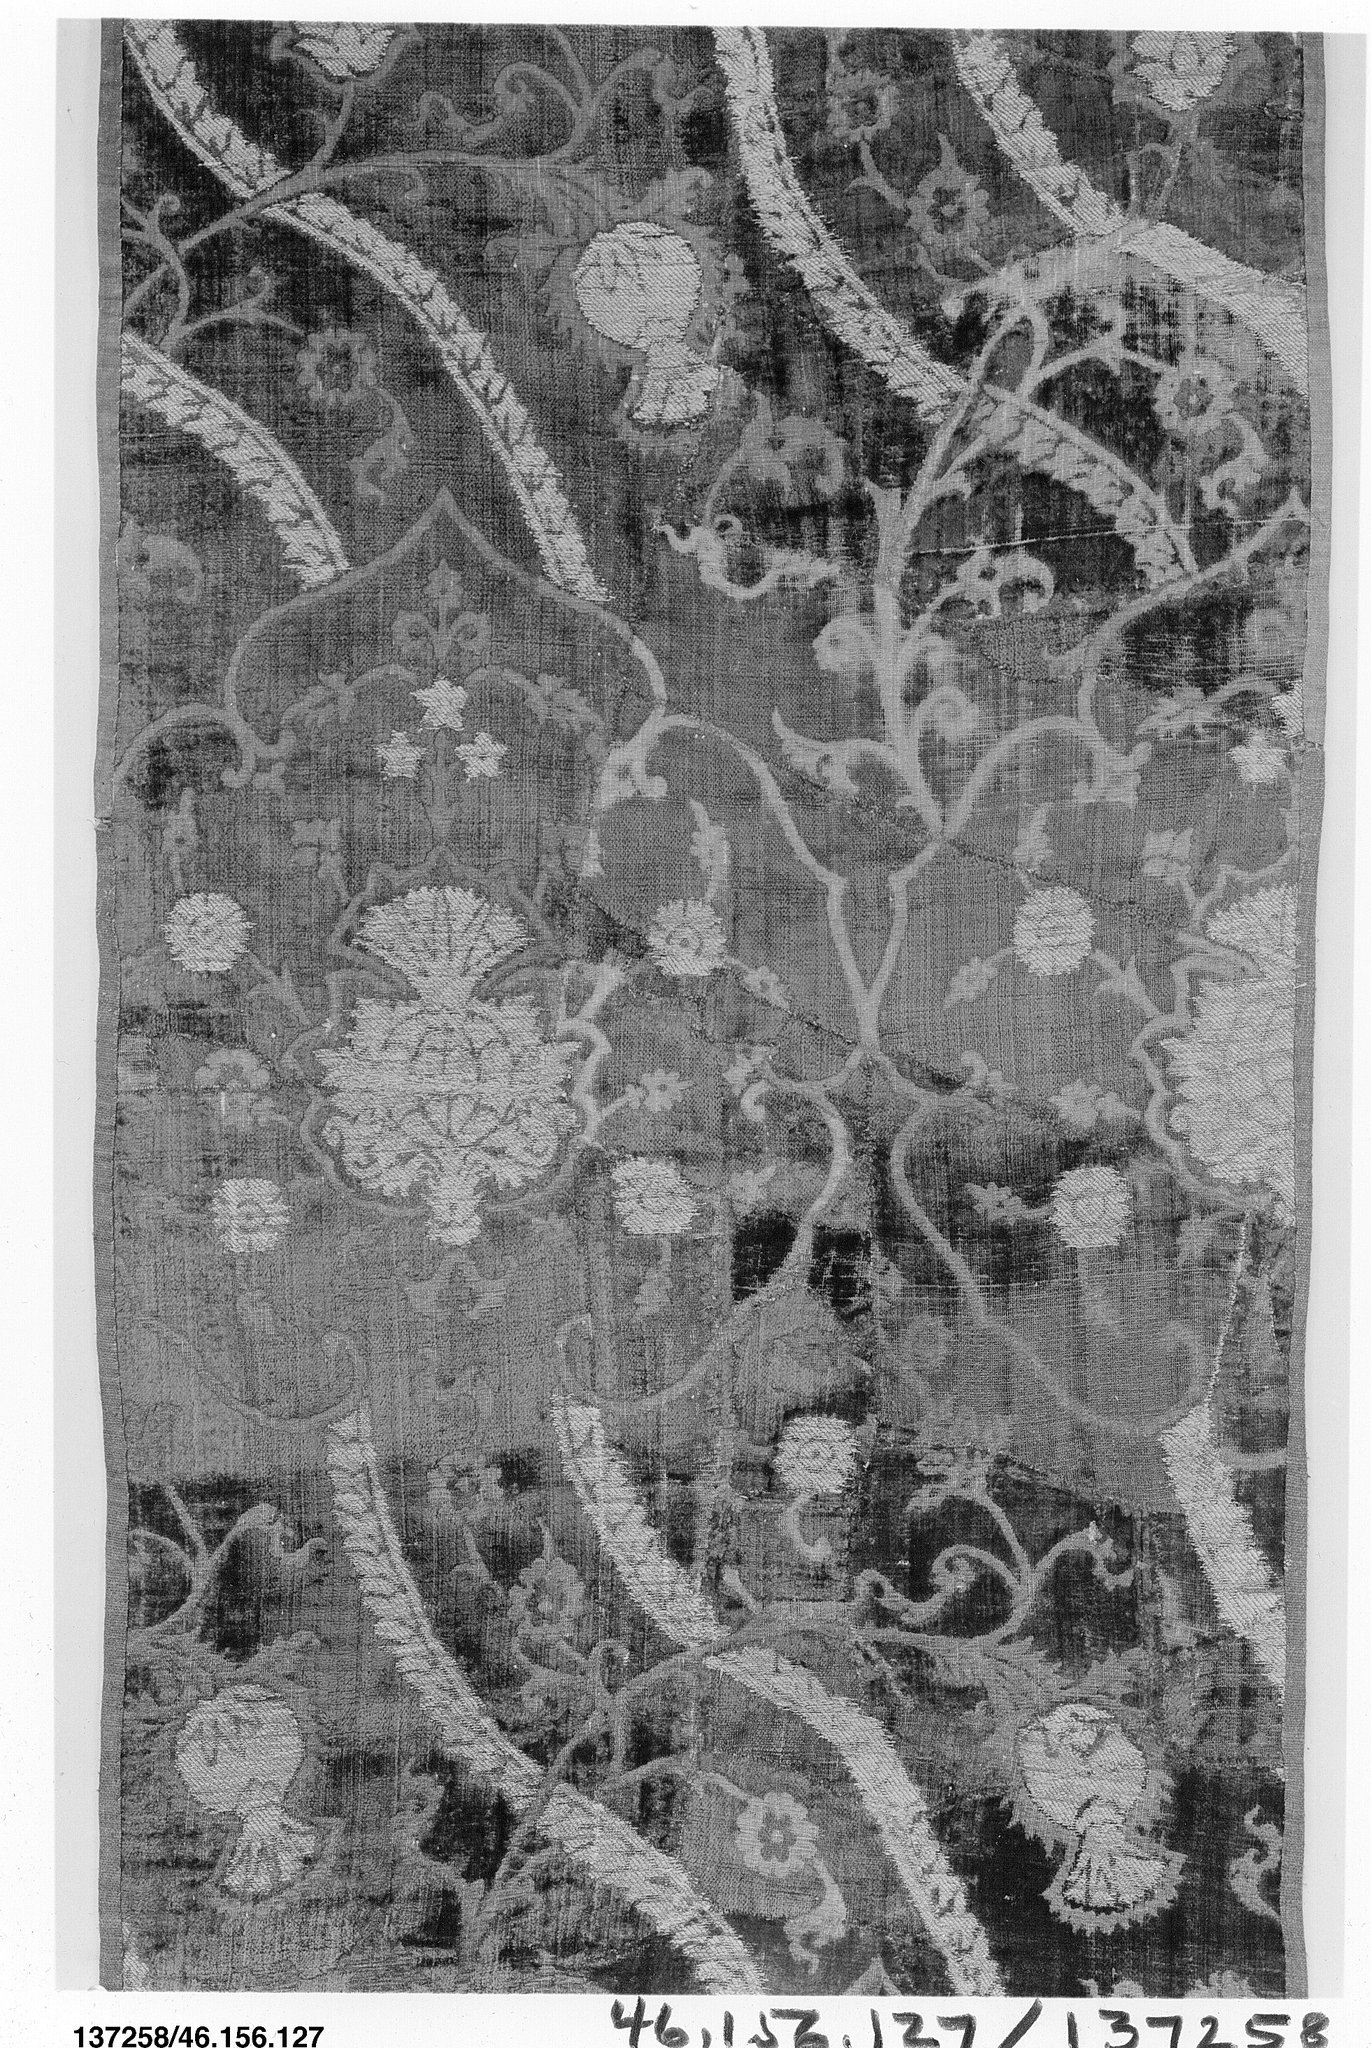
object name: piece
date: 1451-1500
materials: metal thread, silk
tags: flowers,leaves